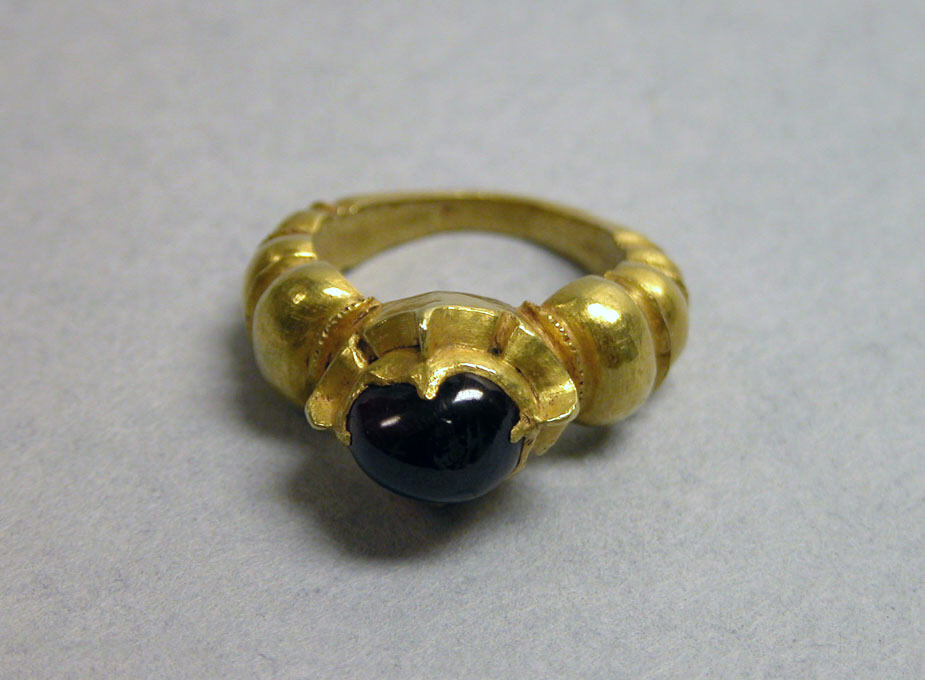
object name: ring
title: Ring with Reddish-purple Stone and Ribbed Hoop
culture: indonesian, javanese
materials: gold, stone